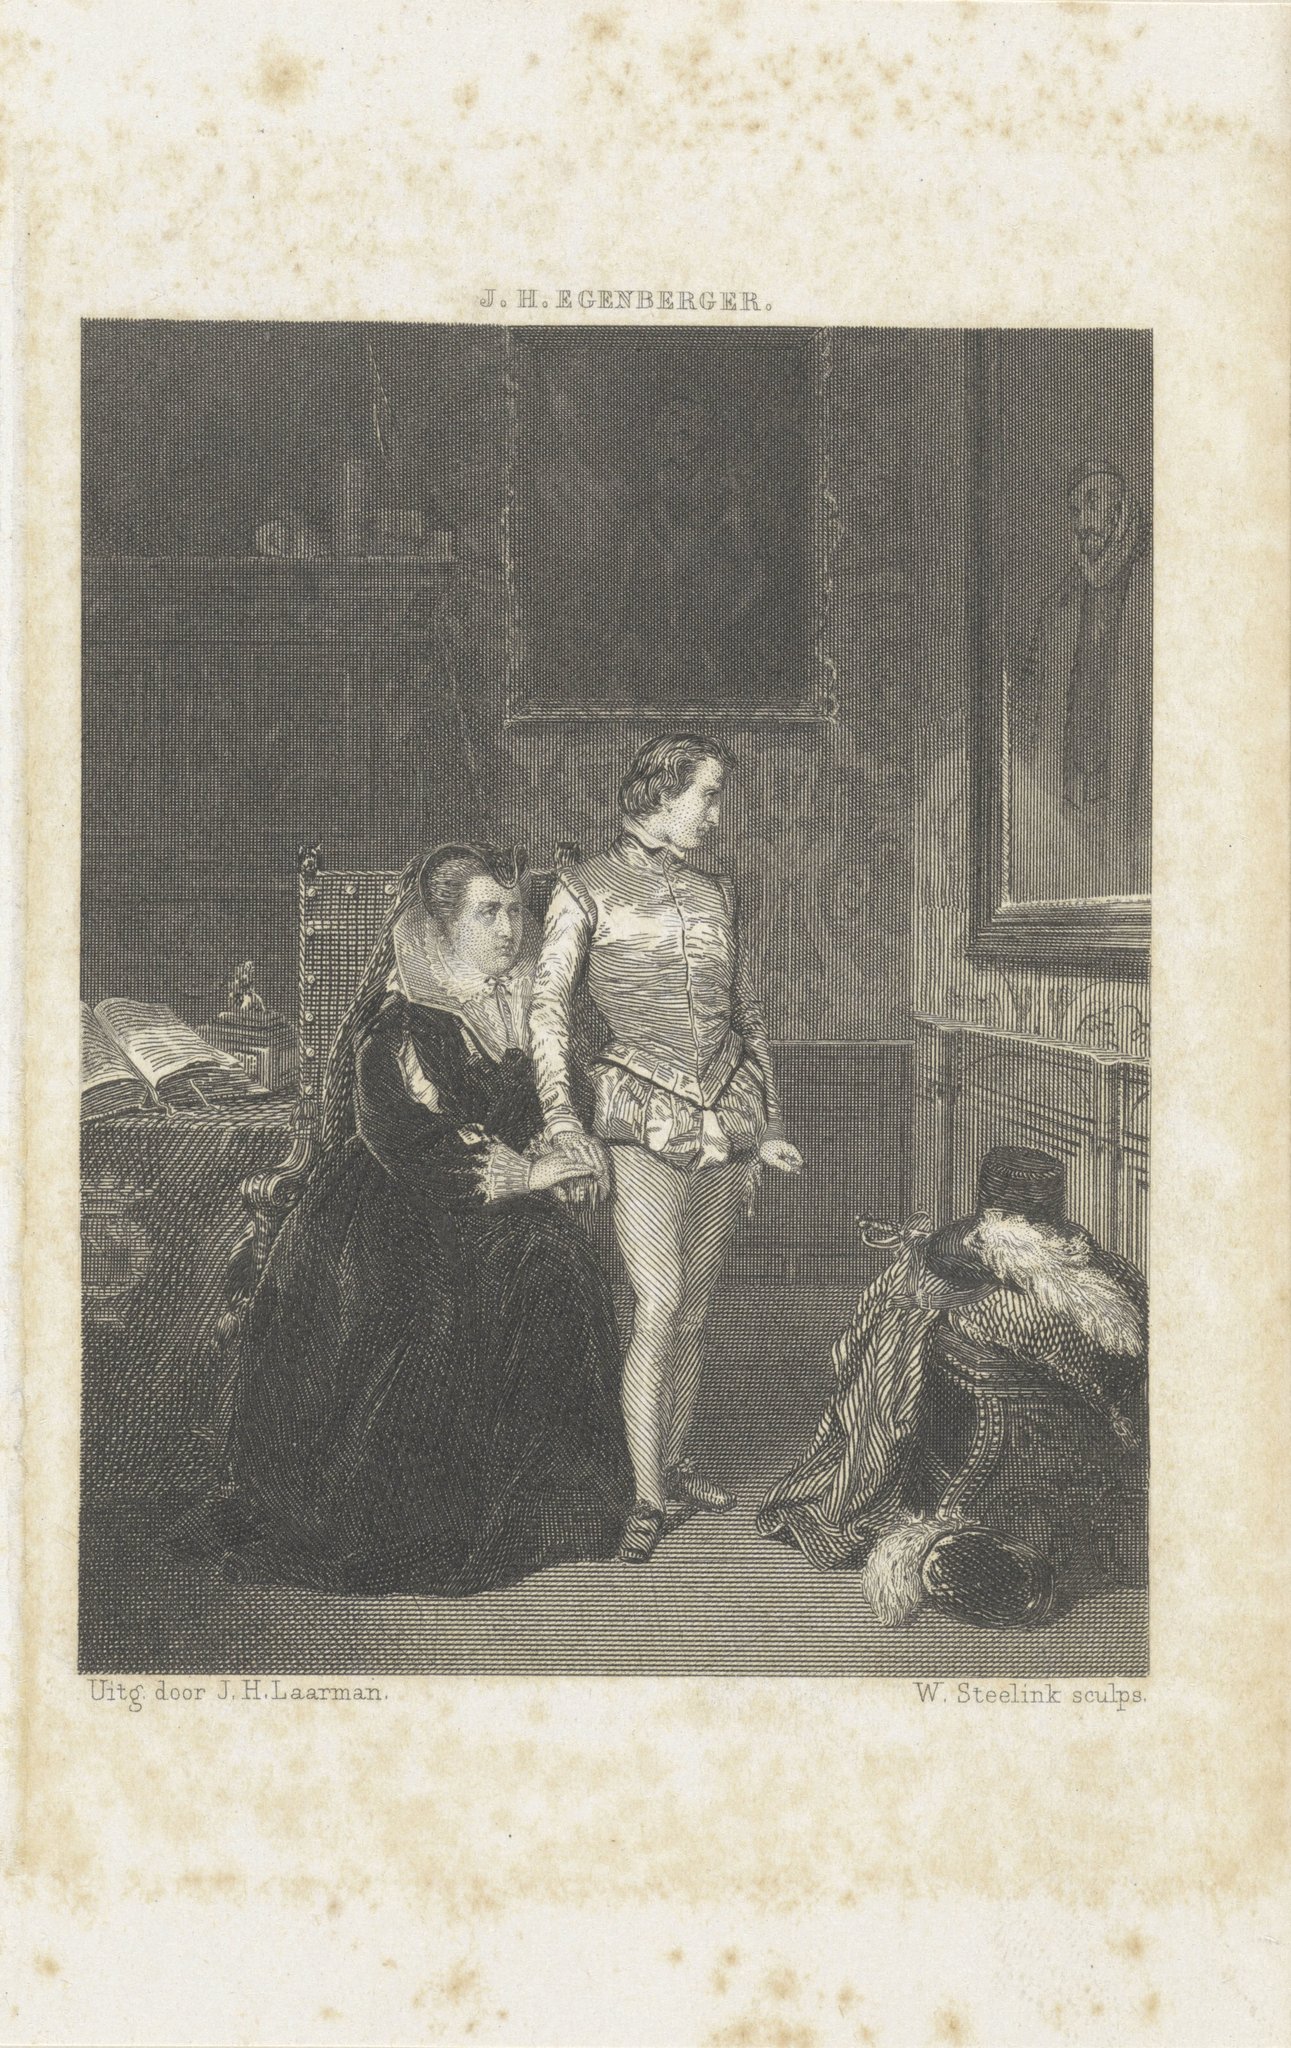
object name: book illustration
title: Louise de Colligny met Frederik Hendrik bij het portret van Willem I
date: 1867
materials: paper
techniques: etching, engraving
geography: amsterdam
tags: louise de coligny, frederick henry (prince of orange), delft, william i (prince of orange), mother and son(s) (family group)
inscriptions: collector's mark: Lugt 2228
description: Een vrouw staat bij een opengeslagen map met prenten of tekeningen en bekijkt ee blad papier. Achter haar staat een schilderij op een ezel.